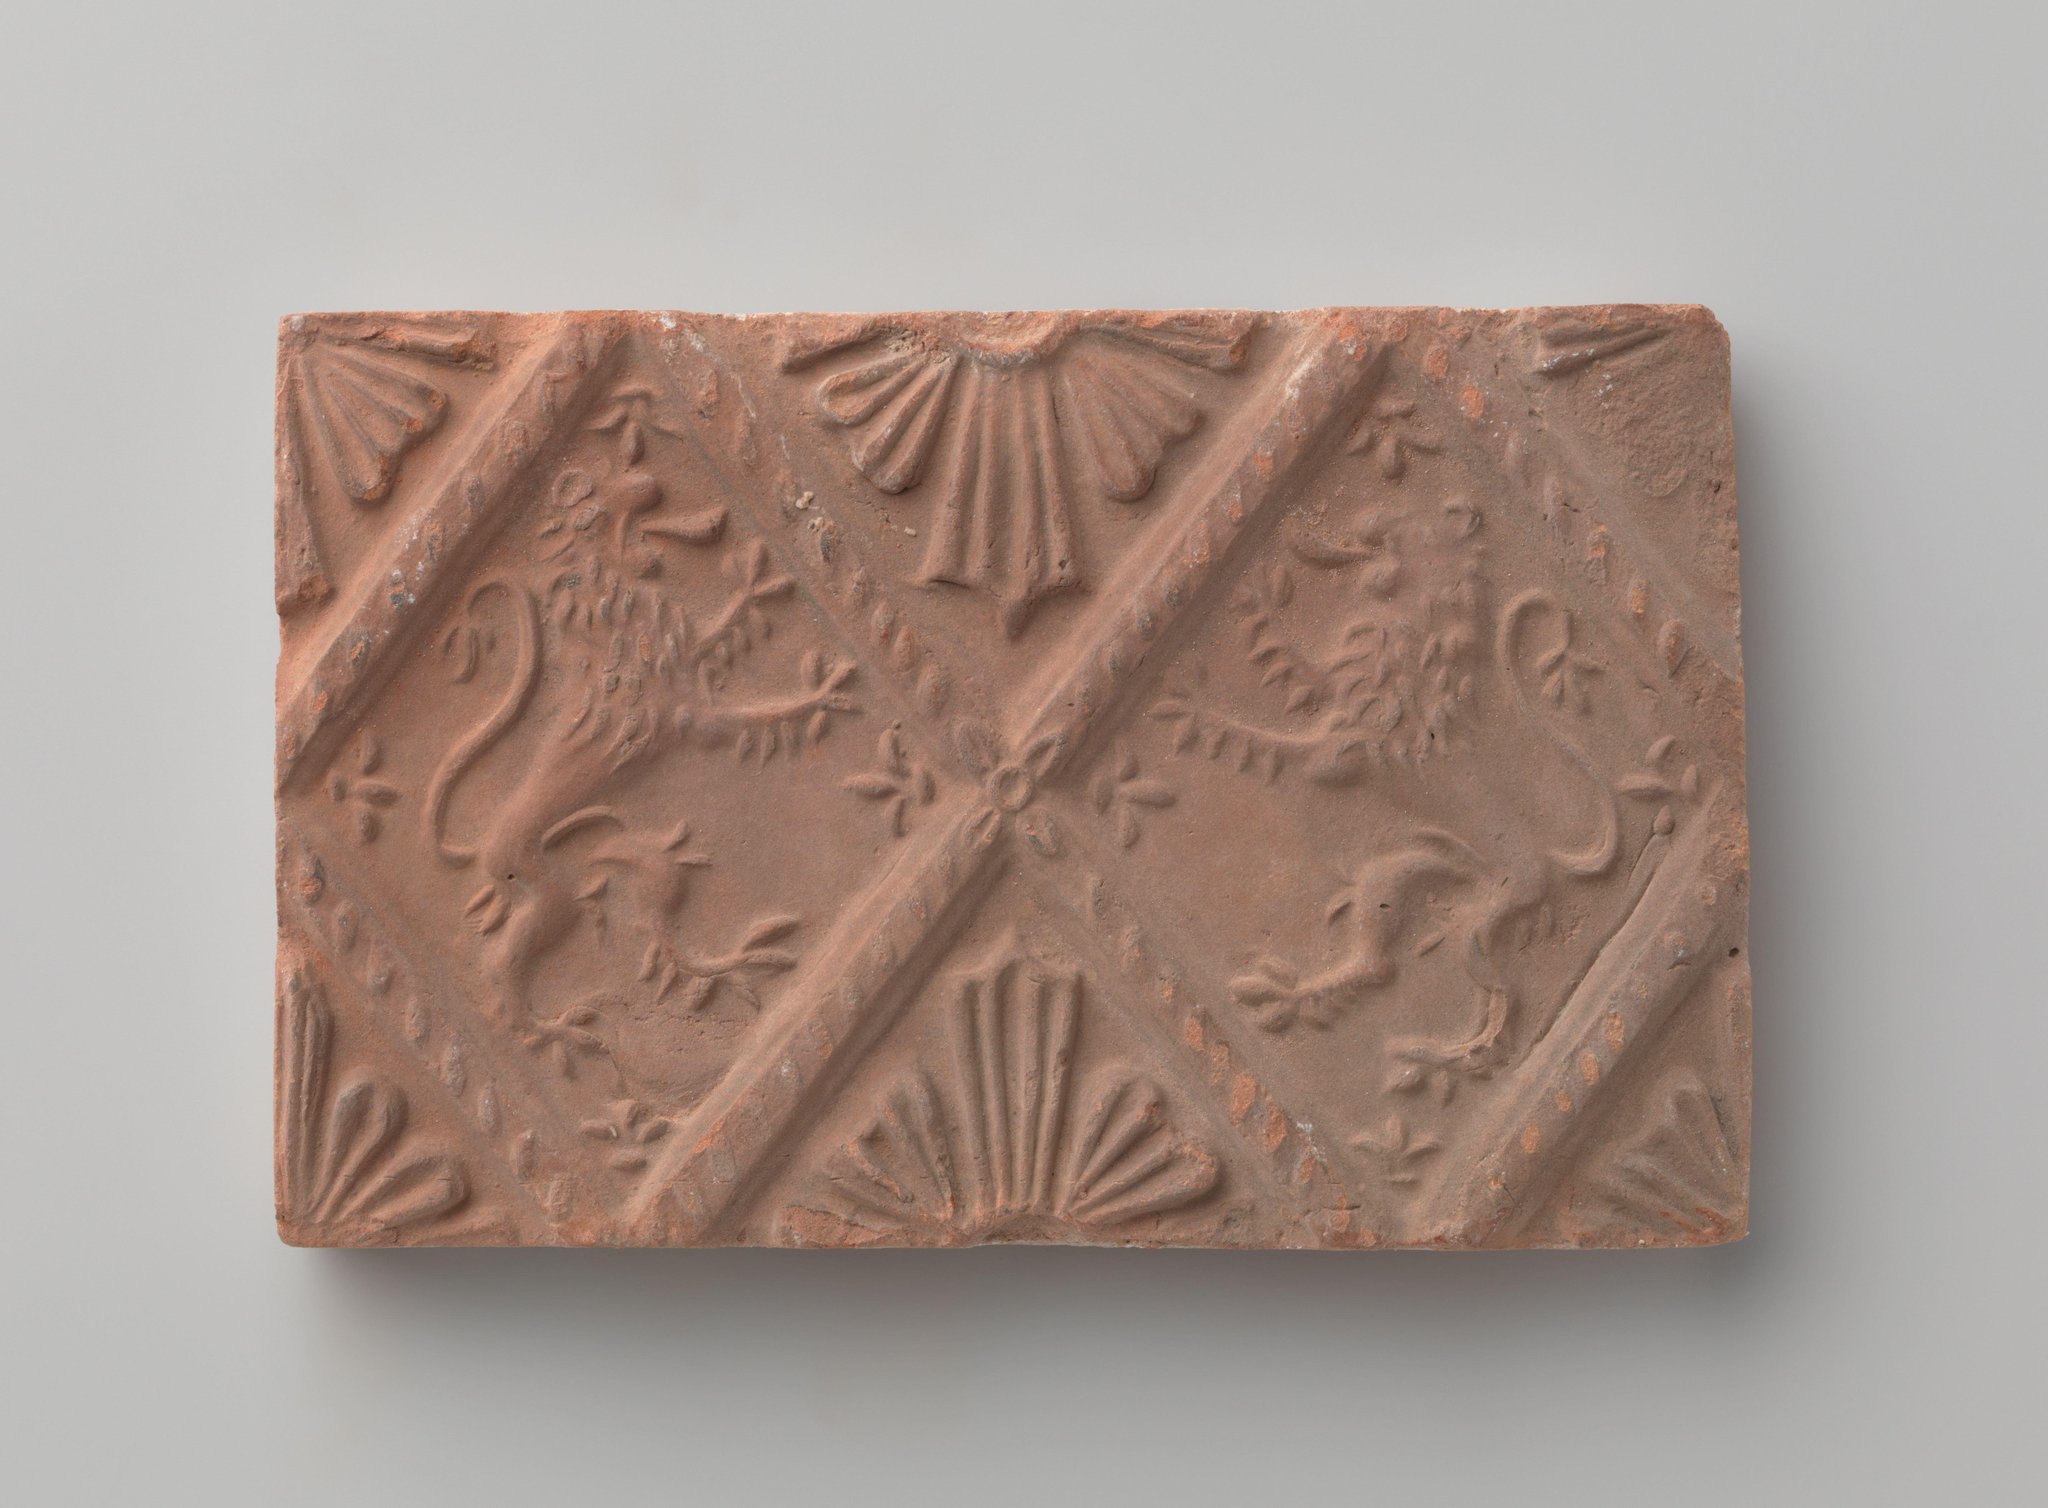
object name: hearthstone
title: Haardsteen met voorstelling van twee klimmende leeuwen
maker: Anonymous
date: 1875-1900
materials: earthenware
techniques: printing, firing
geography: netherlands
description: Haardsteen met voorstelling van twee klimmende leeuwen, geplaatst in geprofileerde ruit. De halve ruiten aan de boven- en onderkant zijn opgevuld met stermotief.